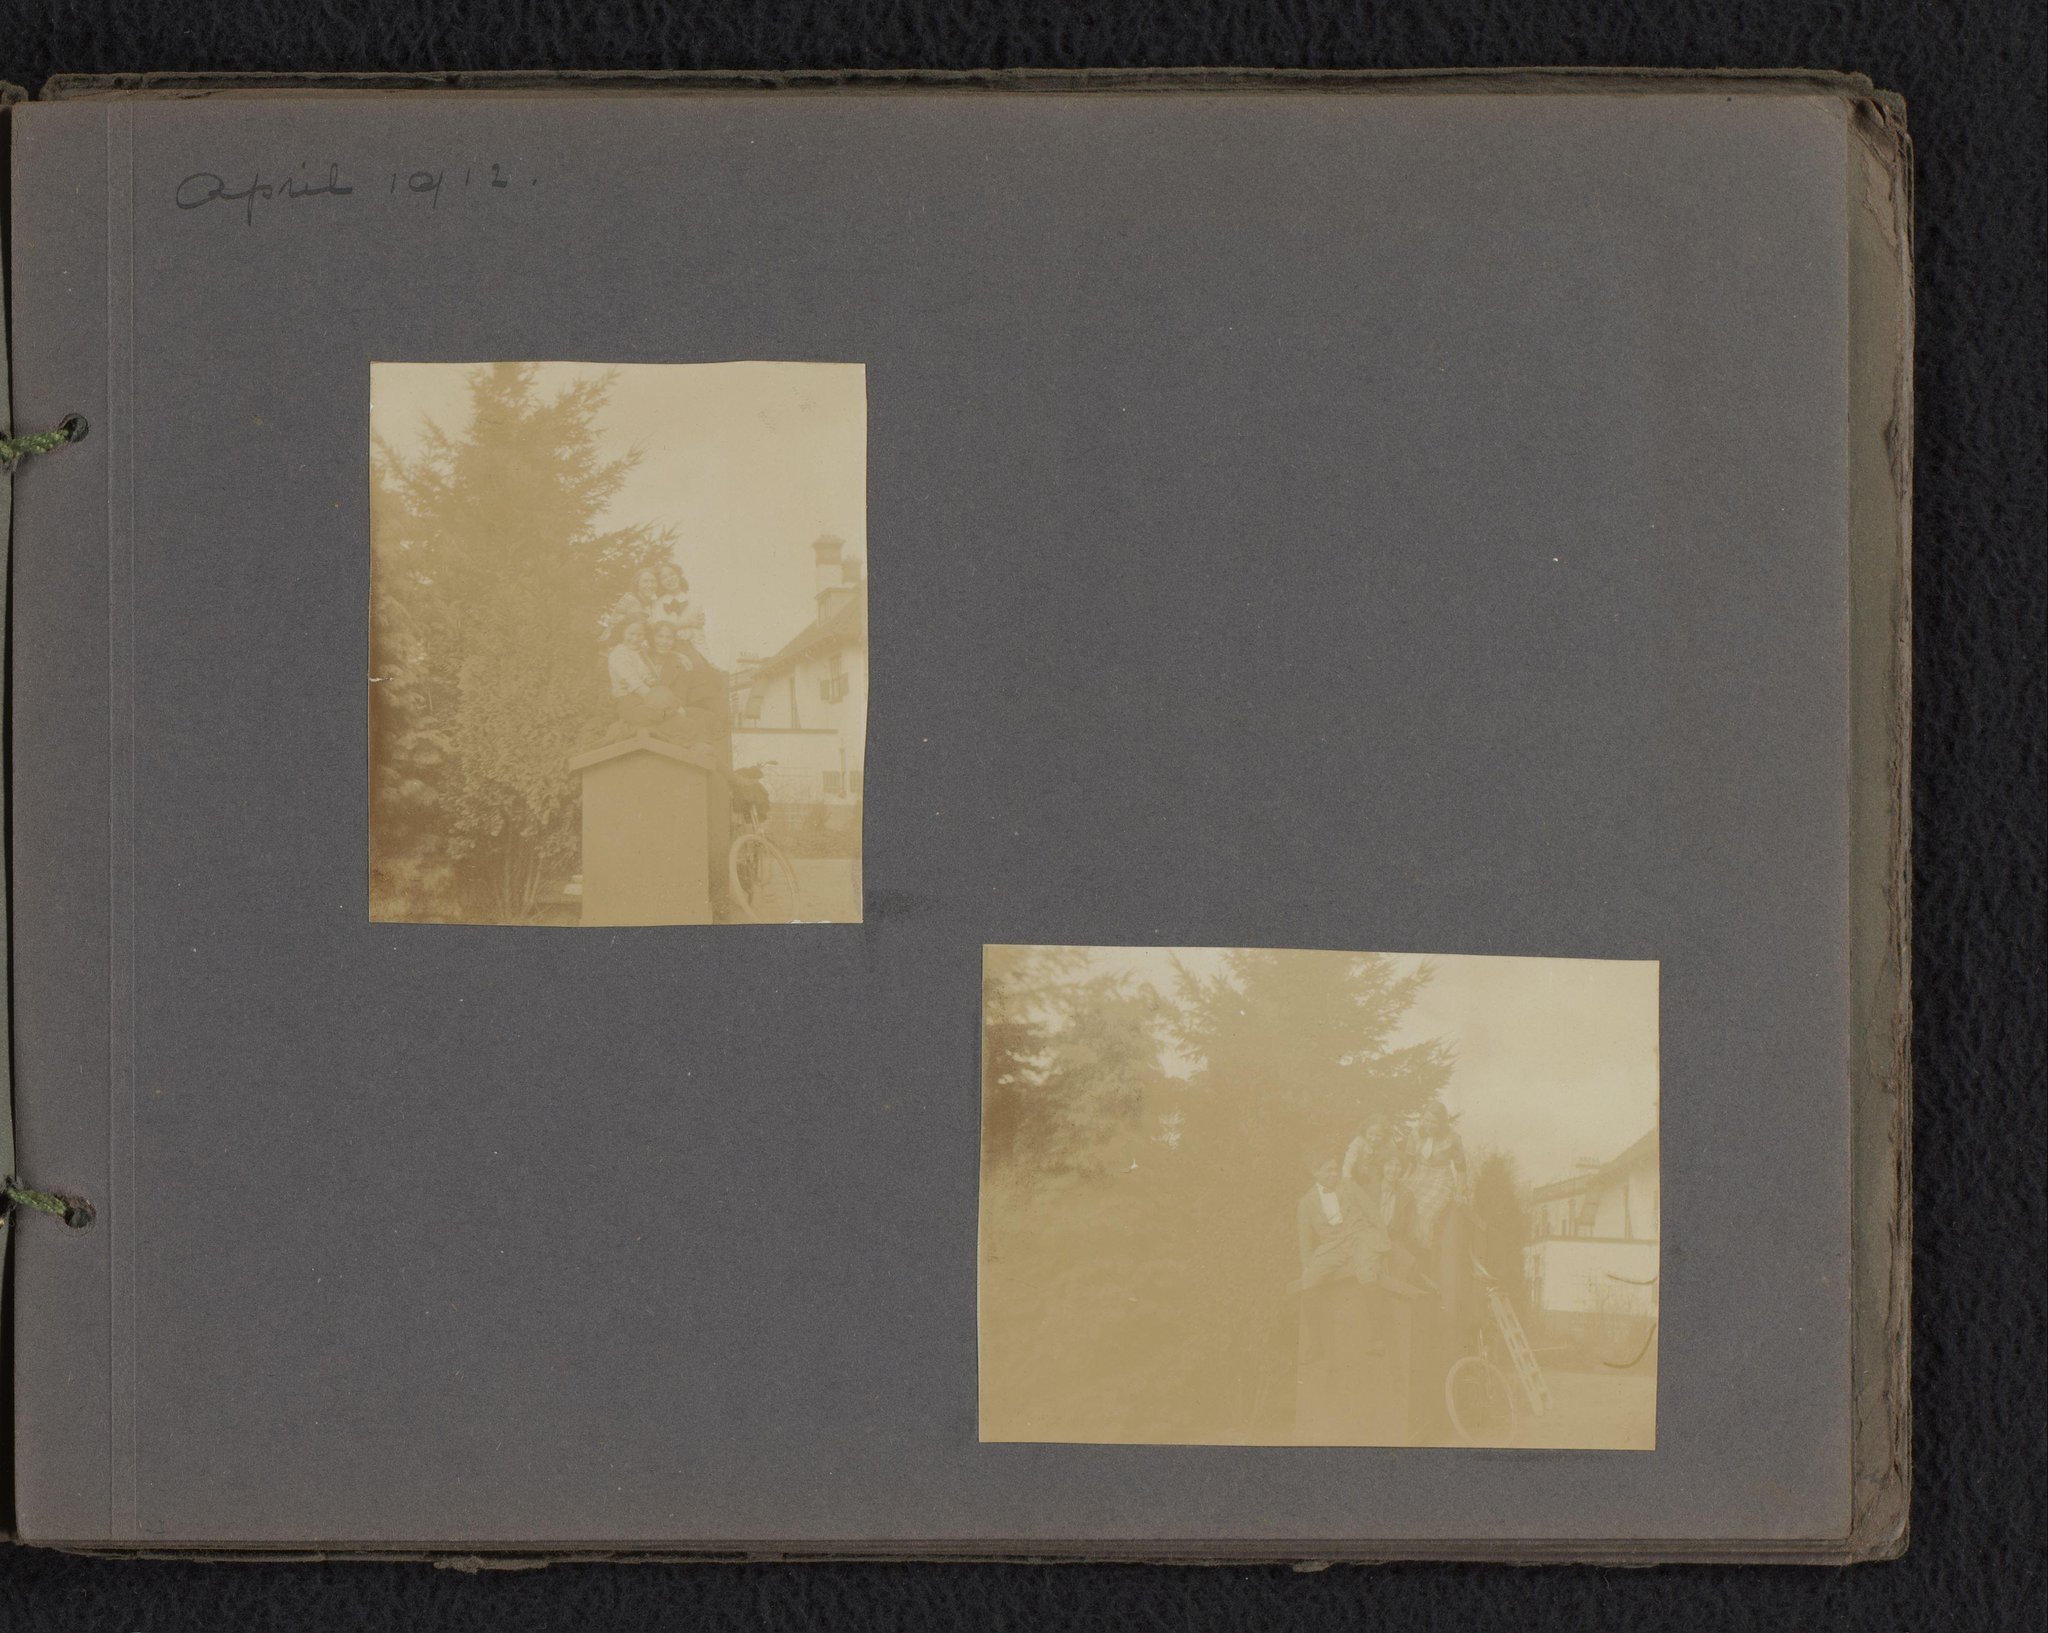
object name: album leaf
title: Loentje Onnen met vriendinnen in de tuin van een woonhuis aan de Bothalaan in Hilversum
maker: carolina frederika onnen (lien/loen)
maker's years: 1896-1983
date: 1904-1912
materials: paper, cardboard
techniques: collodion silver print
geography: hilversum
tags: amsterdam, carolina frederika onnen (lien/loen), garden, friends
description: Deze foto's zijn onderdeel van een album.